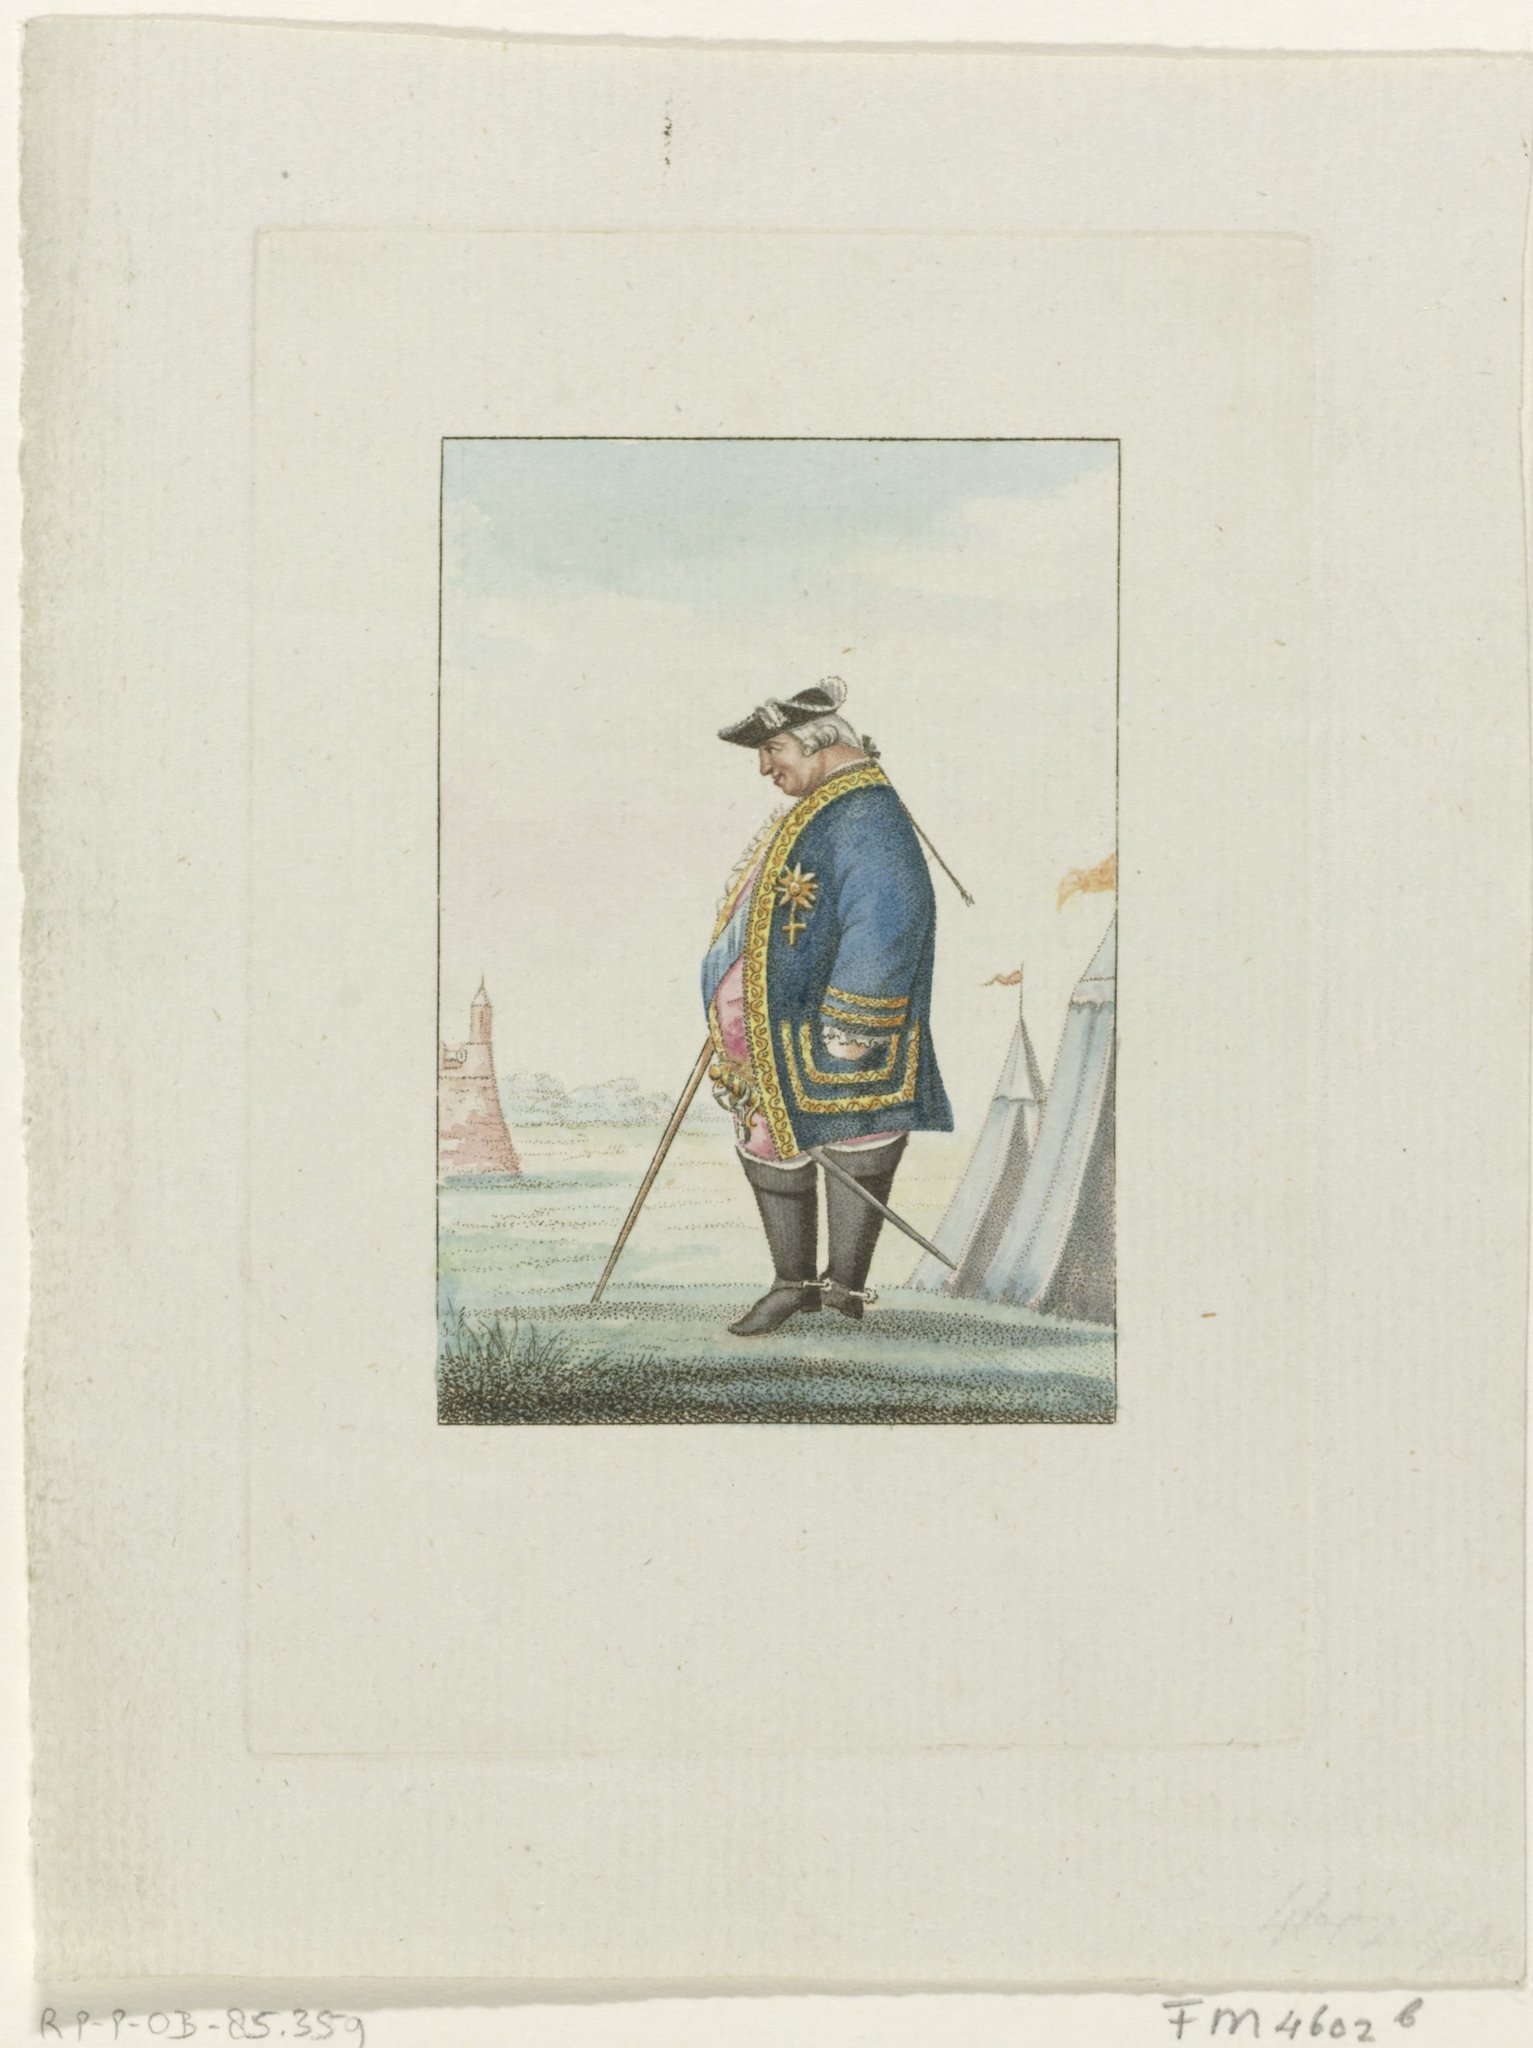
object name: print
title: Portret van de hertog van Brunswijk, 1784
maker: Anonymous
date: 1784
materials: paper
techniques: hand coloring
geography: northern netherlands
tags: ludwig ernst von braunschweig-wolfenbüttel, patriots (1780-1795)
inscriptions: collector's mark: Lugt 2228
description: Portret van de hertog van Brunswijk, staande in veldmaarschalksuniform voor enkele legertenten, ca. 1784.